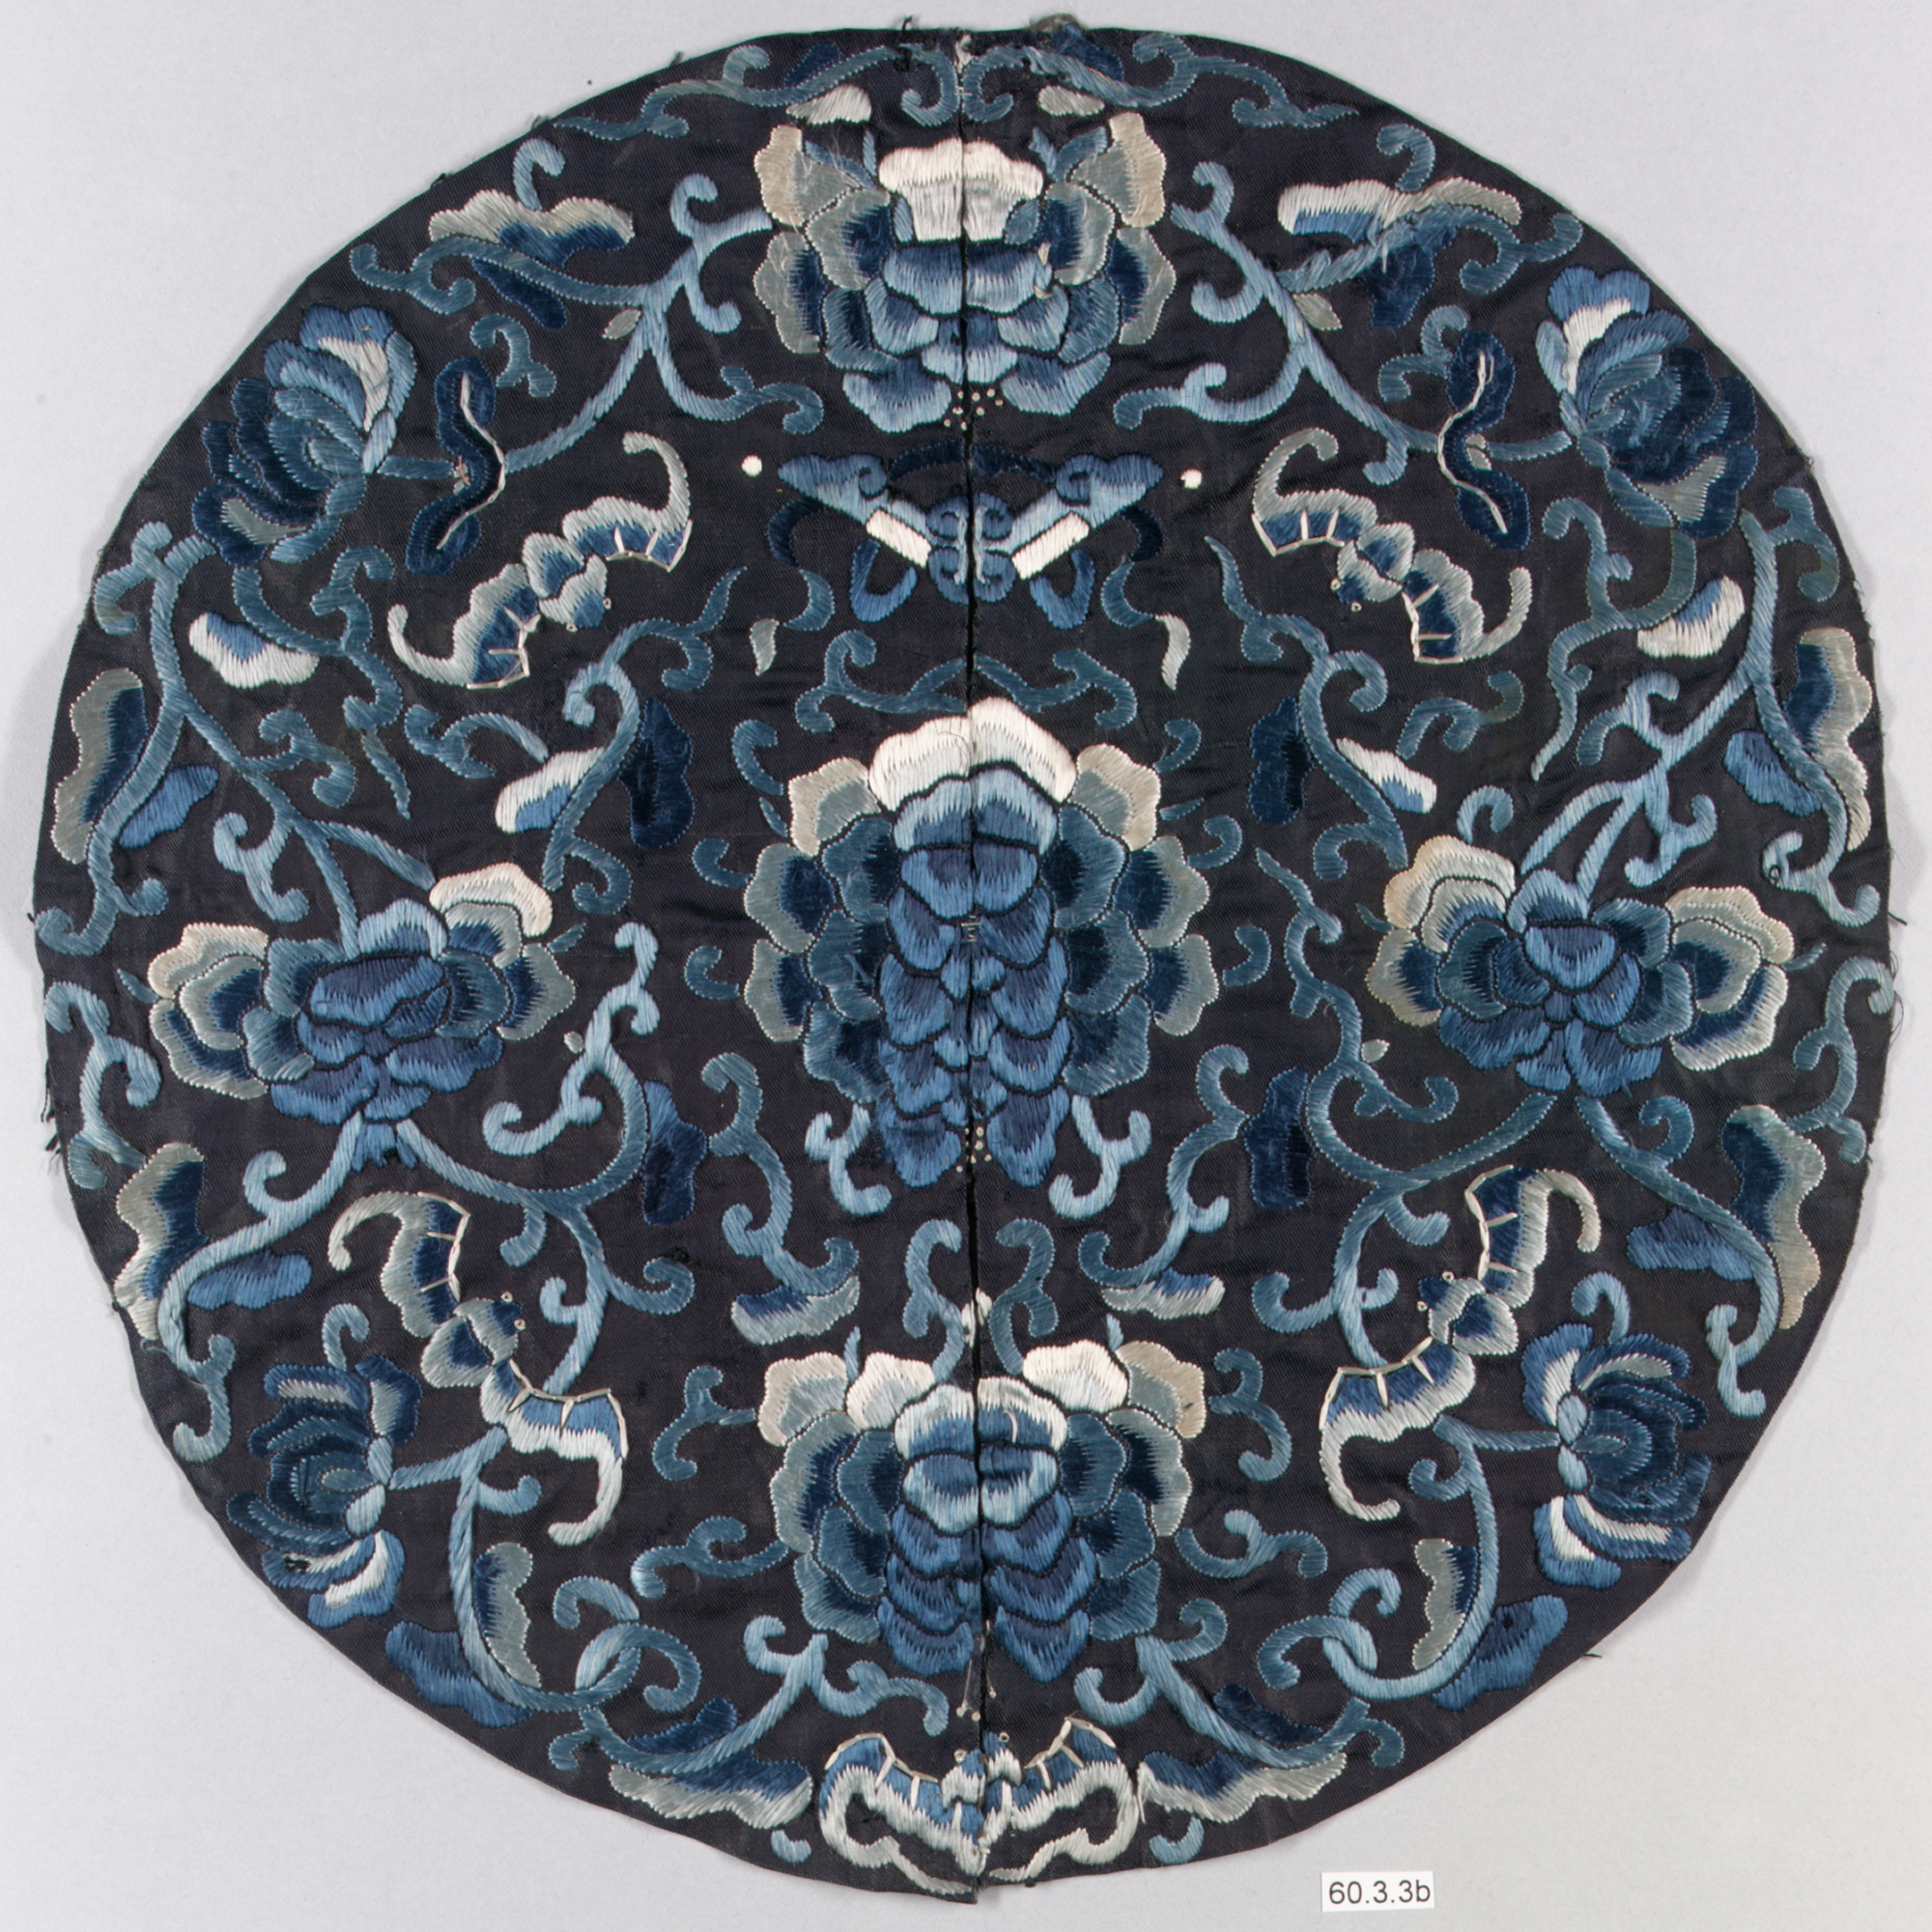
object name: medallion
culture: chinese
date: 1801-1900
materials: silk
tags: flowers